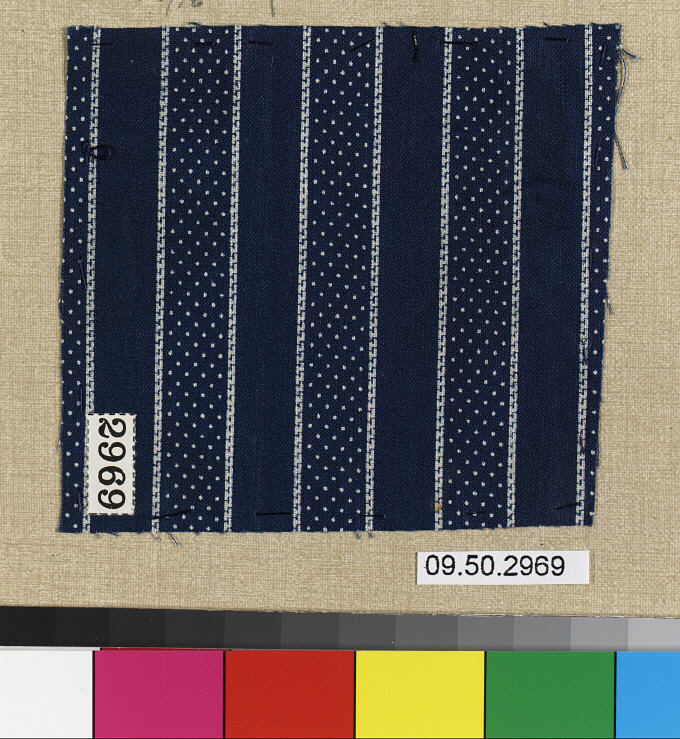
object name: piece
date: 1801-1900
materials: cotton